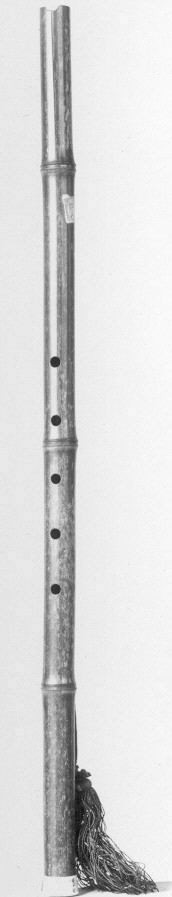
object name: fue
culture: japanese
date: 1801-1900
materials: bamboo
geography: japan